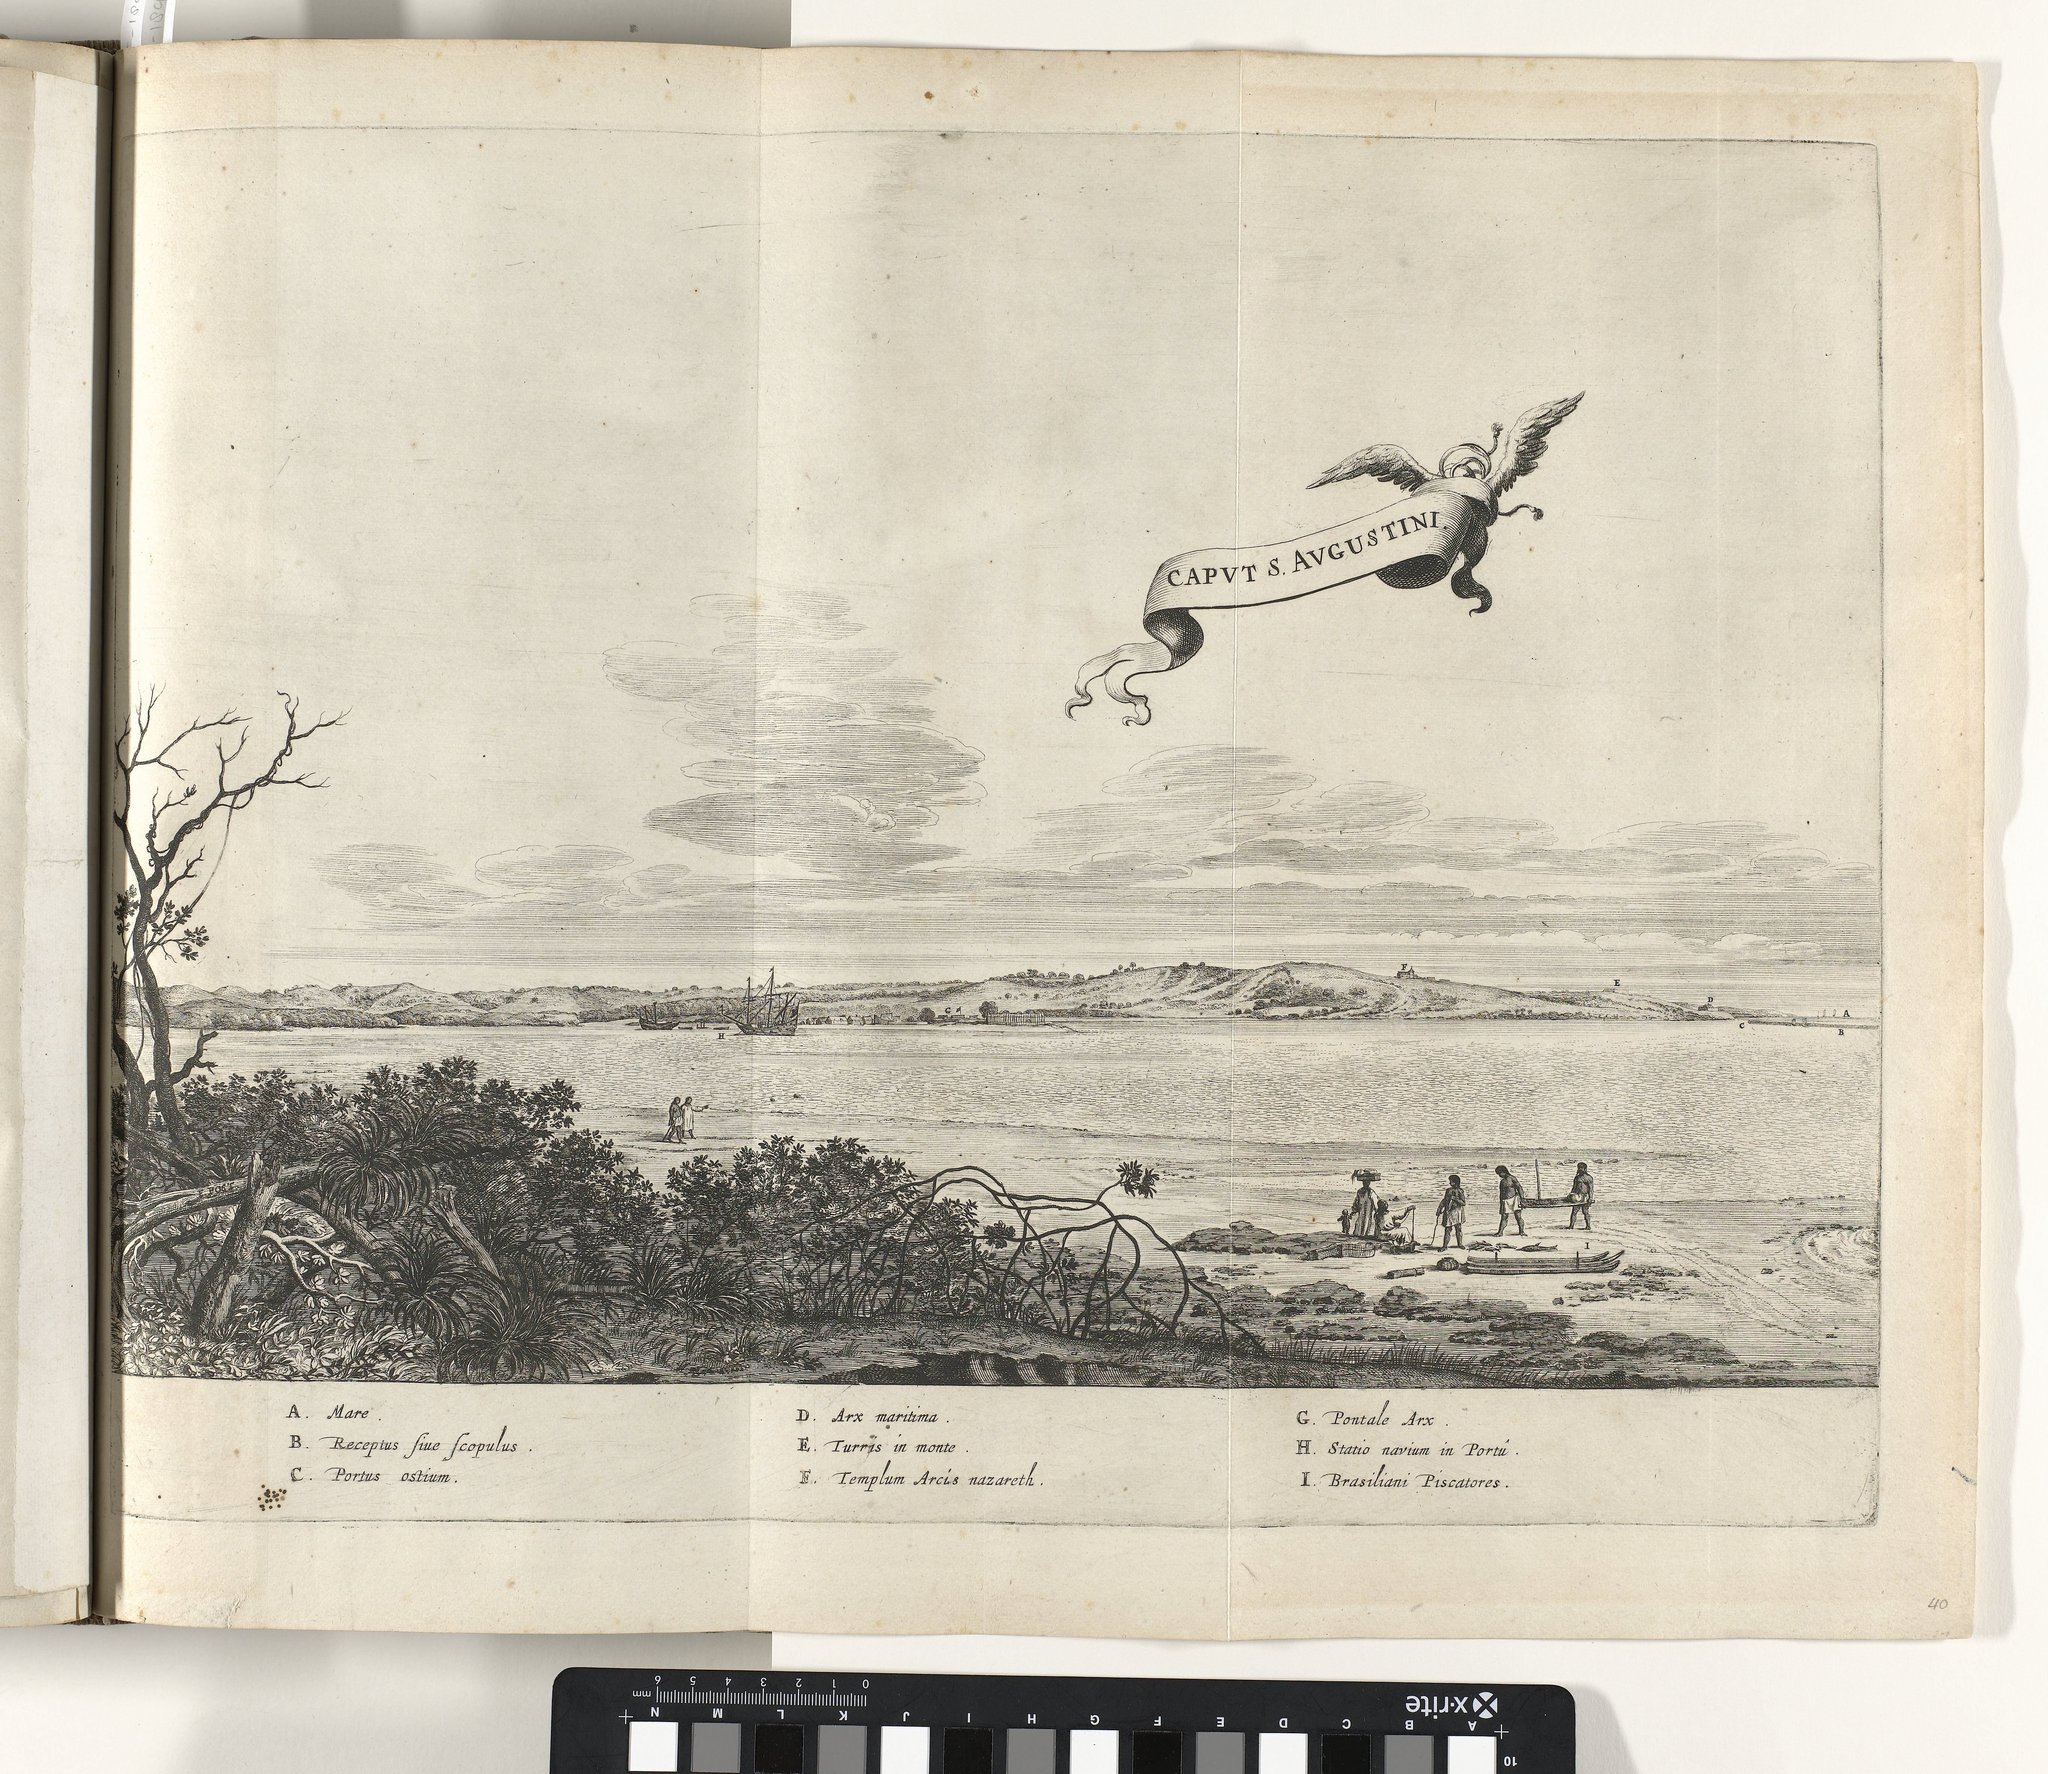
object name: print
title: Gezicht op kaap Sint Augustijn, ca. 1636-1644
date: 1645-1647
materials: paper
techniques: engraving, etching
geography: northern netherlands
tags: earl, johan maurits graaf van nassau-siegen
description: Kaart van kaap Sint Augustijn (Cabo de Santo Agostinho) met de daargelegen forten, in Pernambuco, ca. 1636-1644. In de lucht een gevleugelde banderol met de titel. In het onderschrift de verklaring van de letters A-I in het Latijn. Plaat [nr. 37] in een serie van 55 voorstellingen van de tocht naar en het verblijf in Brazilië van graaf Johan Maurits van Nassau in de jaren 1636-1644.